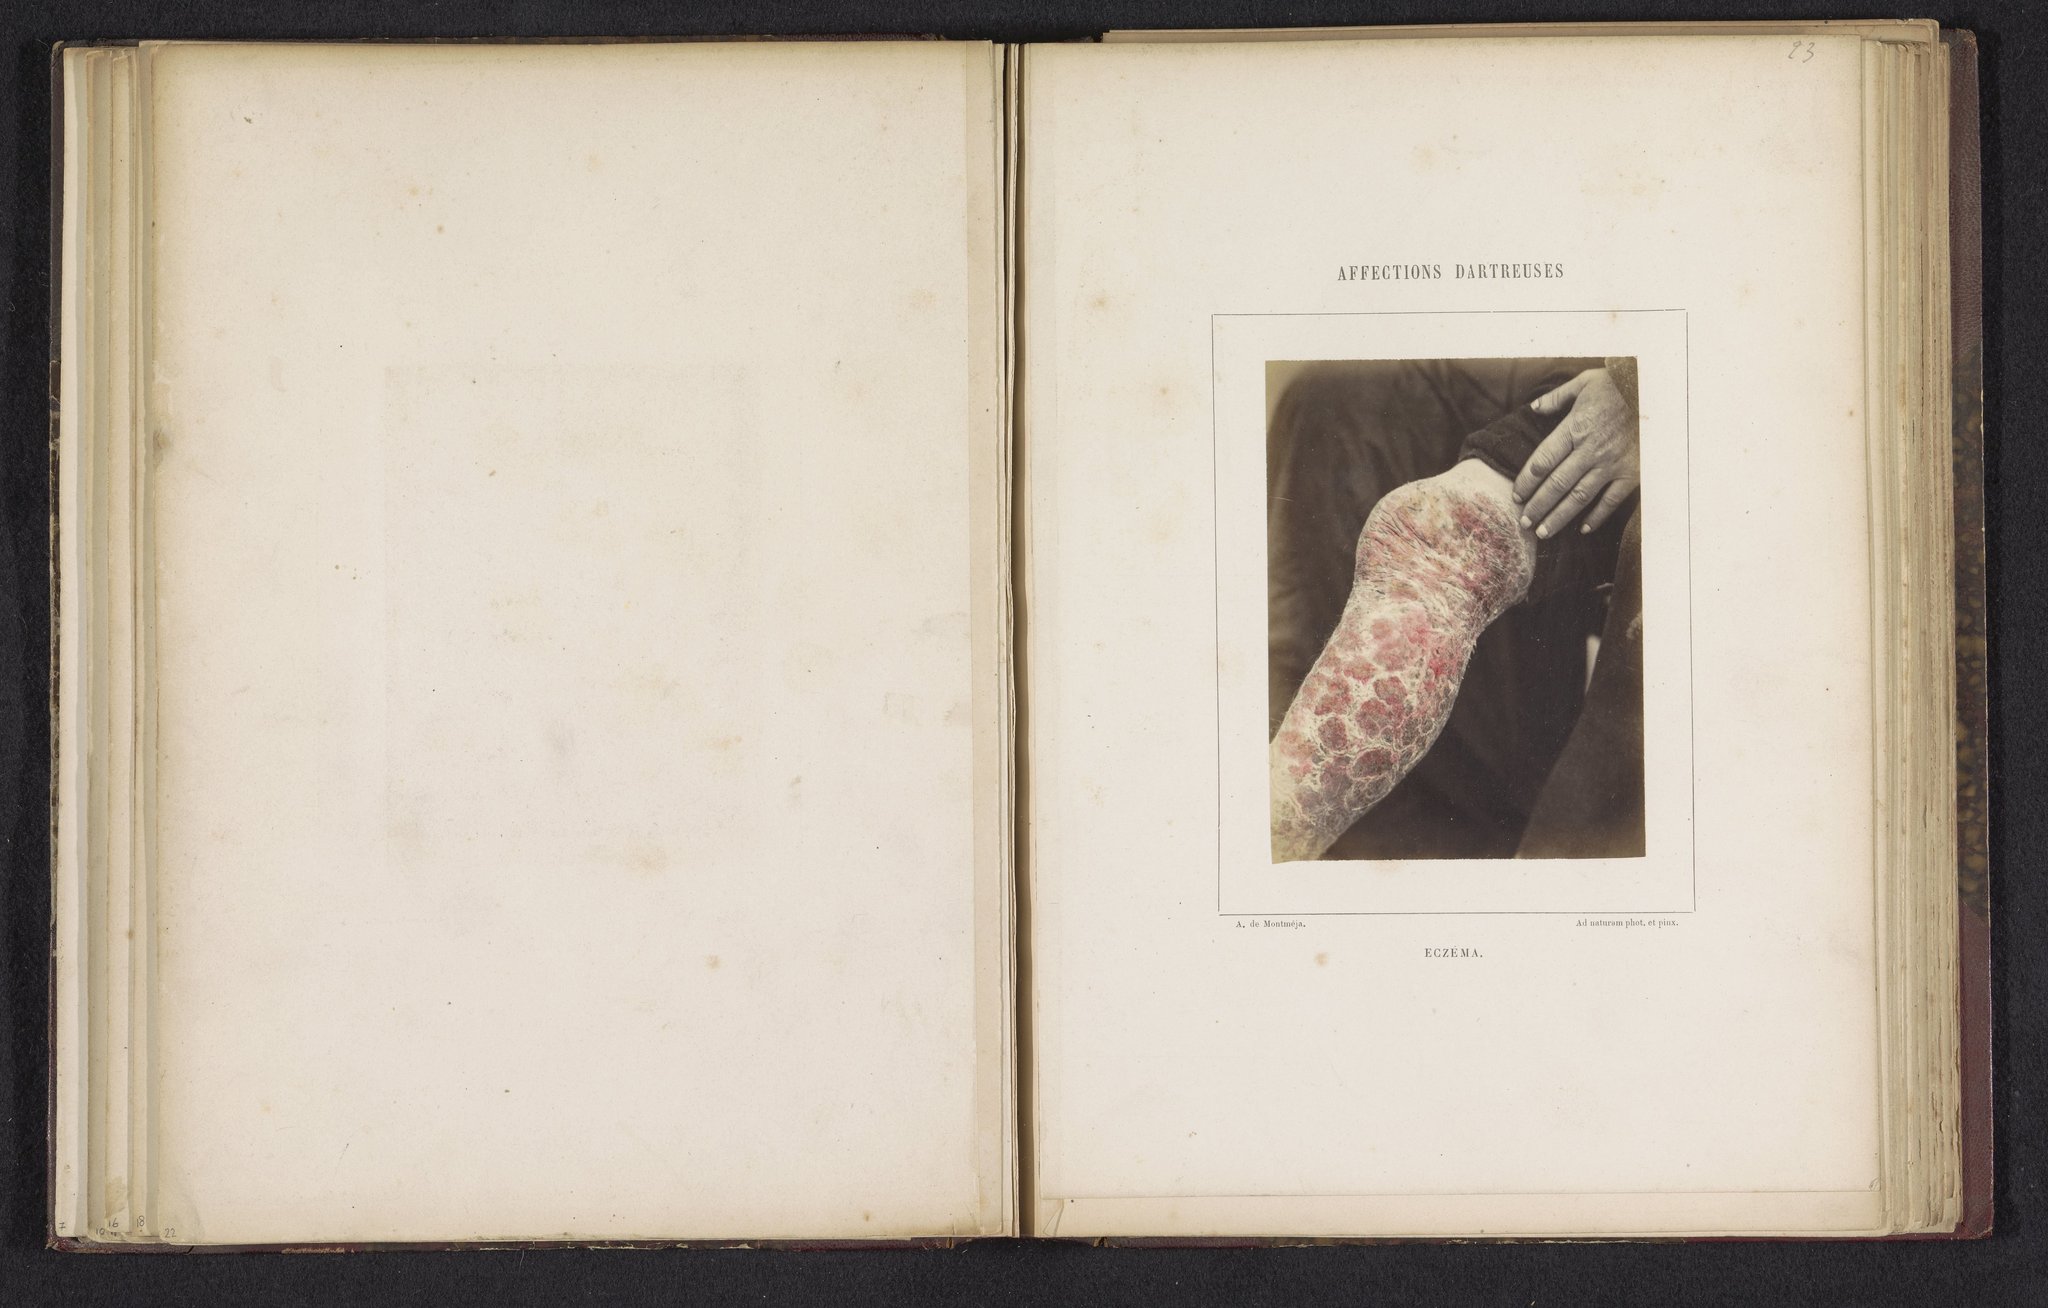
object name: page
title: Been met eczeem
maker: a. de montméja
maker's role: arts, fotograaf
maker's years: 1841-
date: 1860-1868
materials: photographic support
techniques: albumen print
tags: skin and venereal diseases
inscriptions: inscription: ‘Ad naturam phot. et pinx.’, number: ‘23’, inscription: ‘Affections dartreuses’